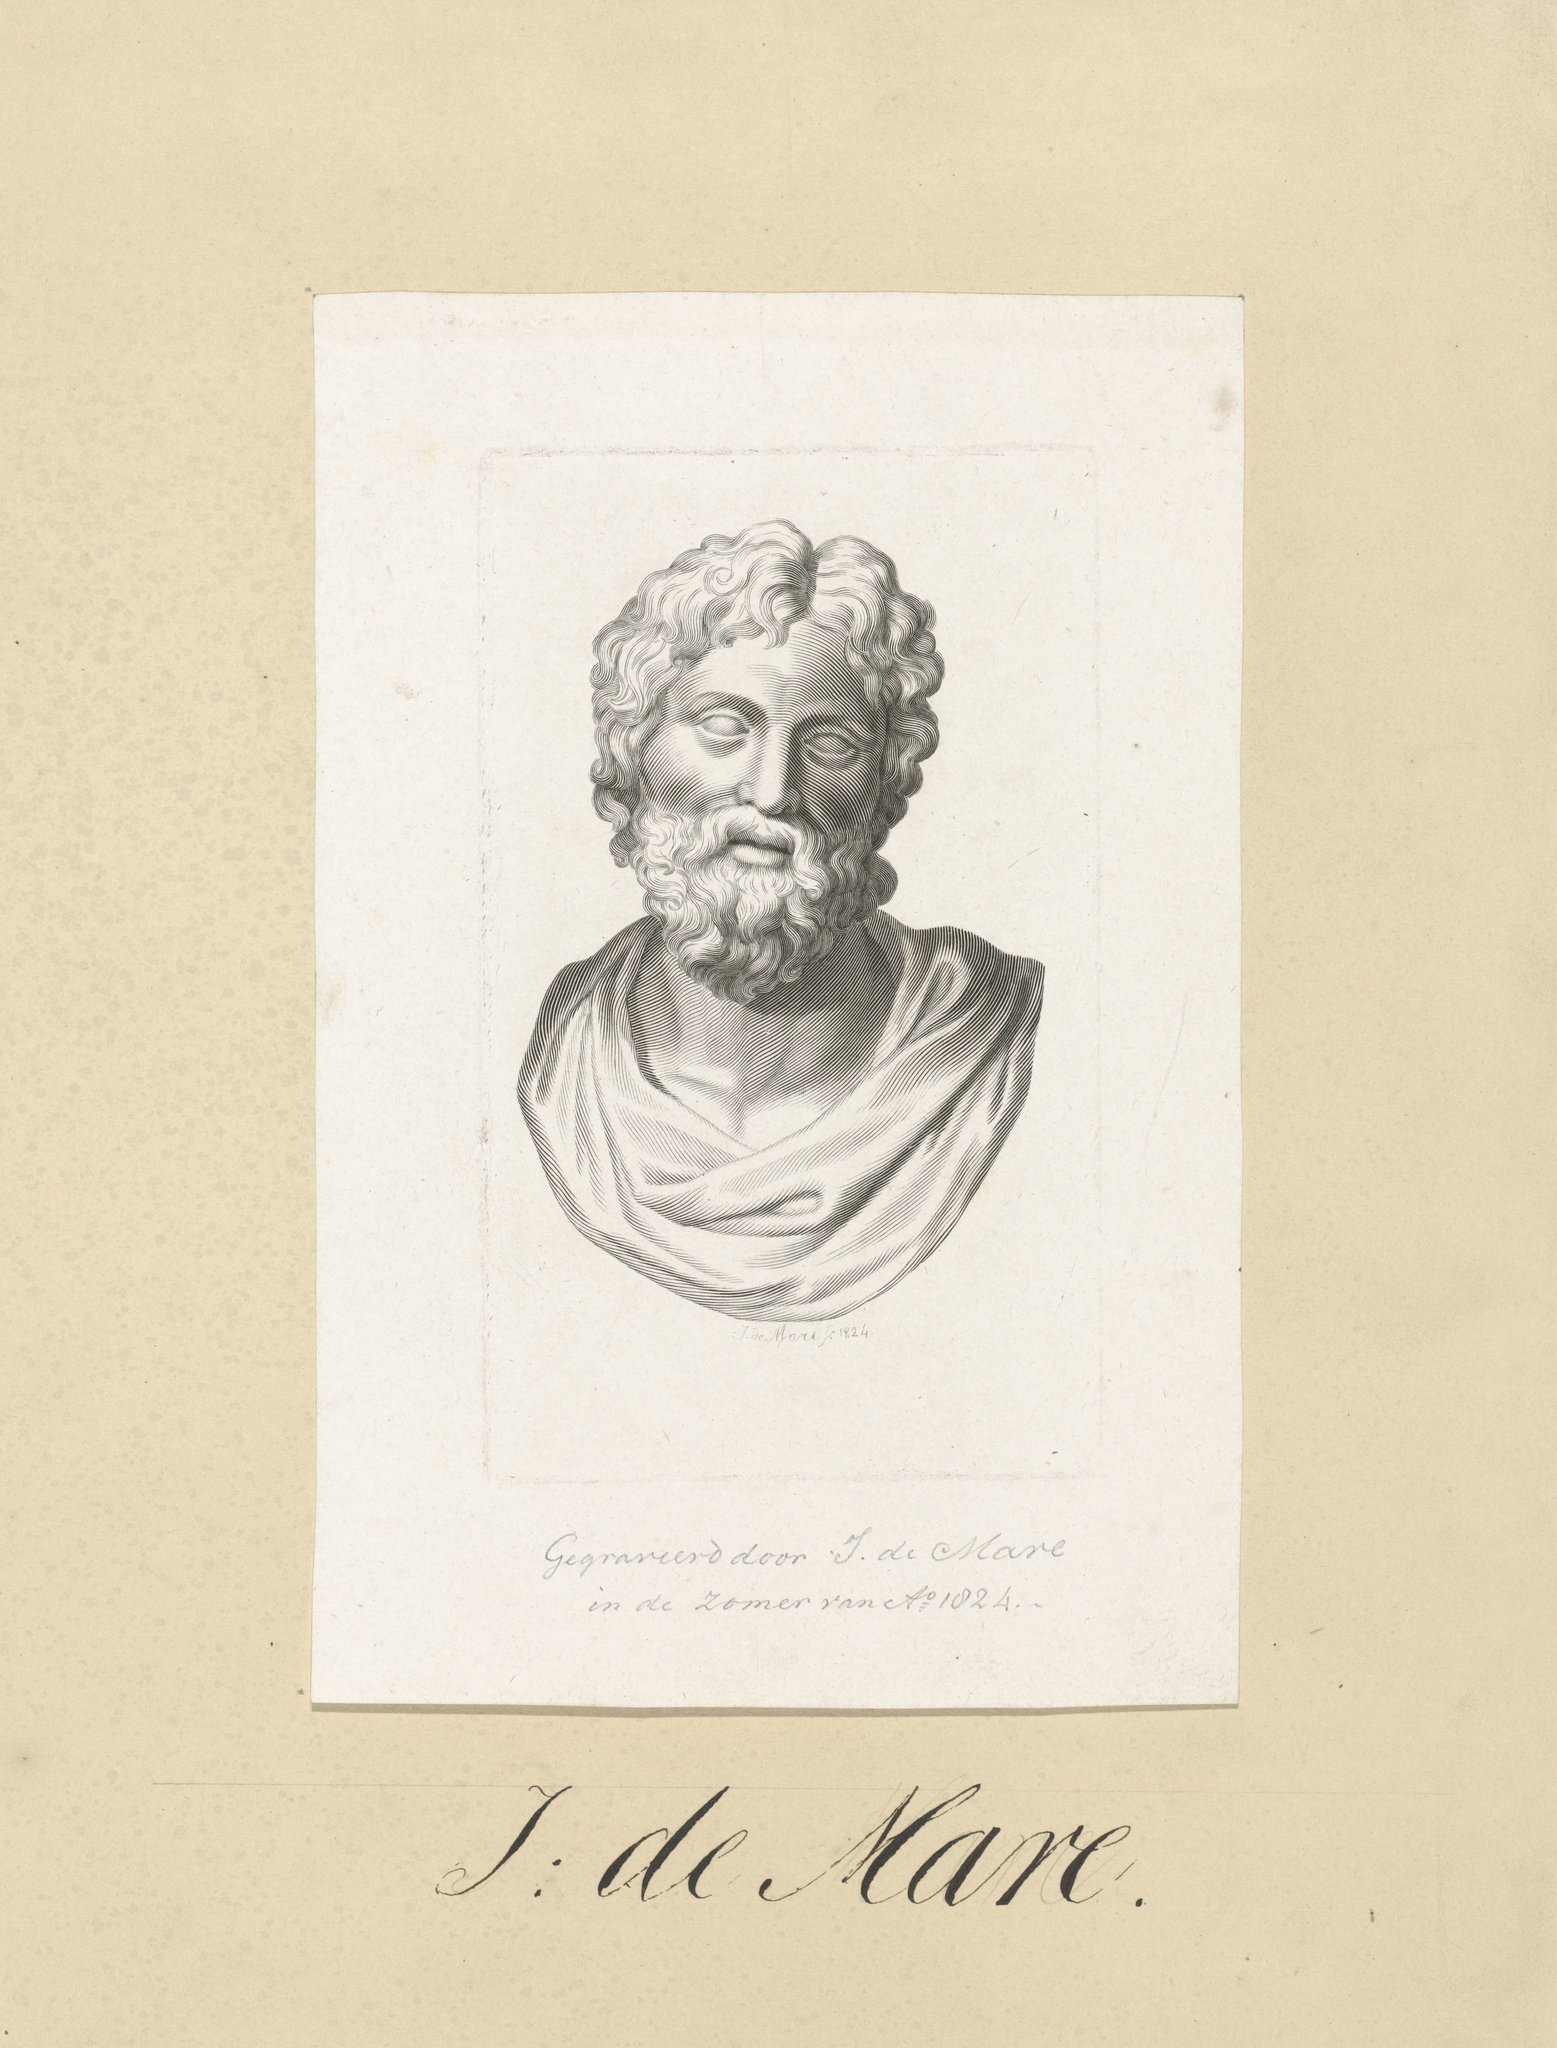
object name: print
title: Mannenkop naar Grieks voorbeeld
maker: johannes de mare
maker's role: draughtsman, print maker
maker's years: 1806-1889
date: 1824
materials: paper, pencil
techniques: engraving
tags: piece of sculpture, reproduction of a piece of sculpture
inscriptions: inscription: ‘Gegraveerd door J. de Mare/ in de zomer van Ao. 1824’, collector's mark: Lugt 2228